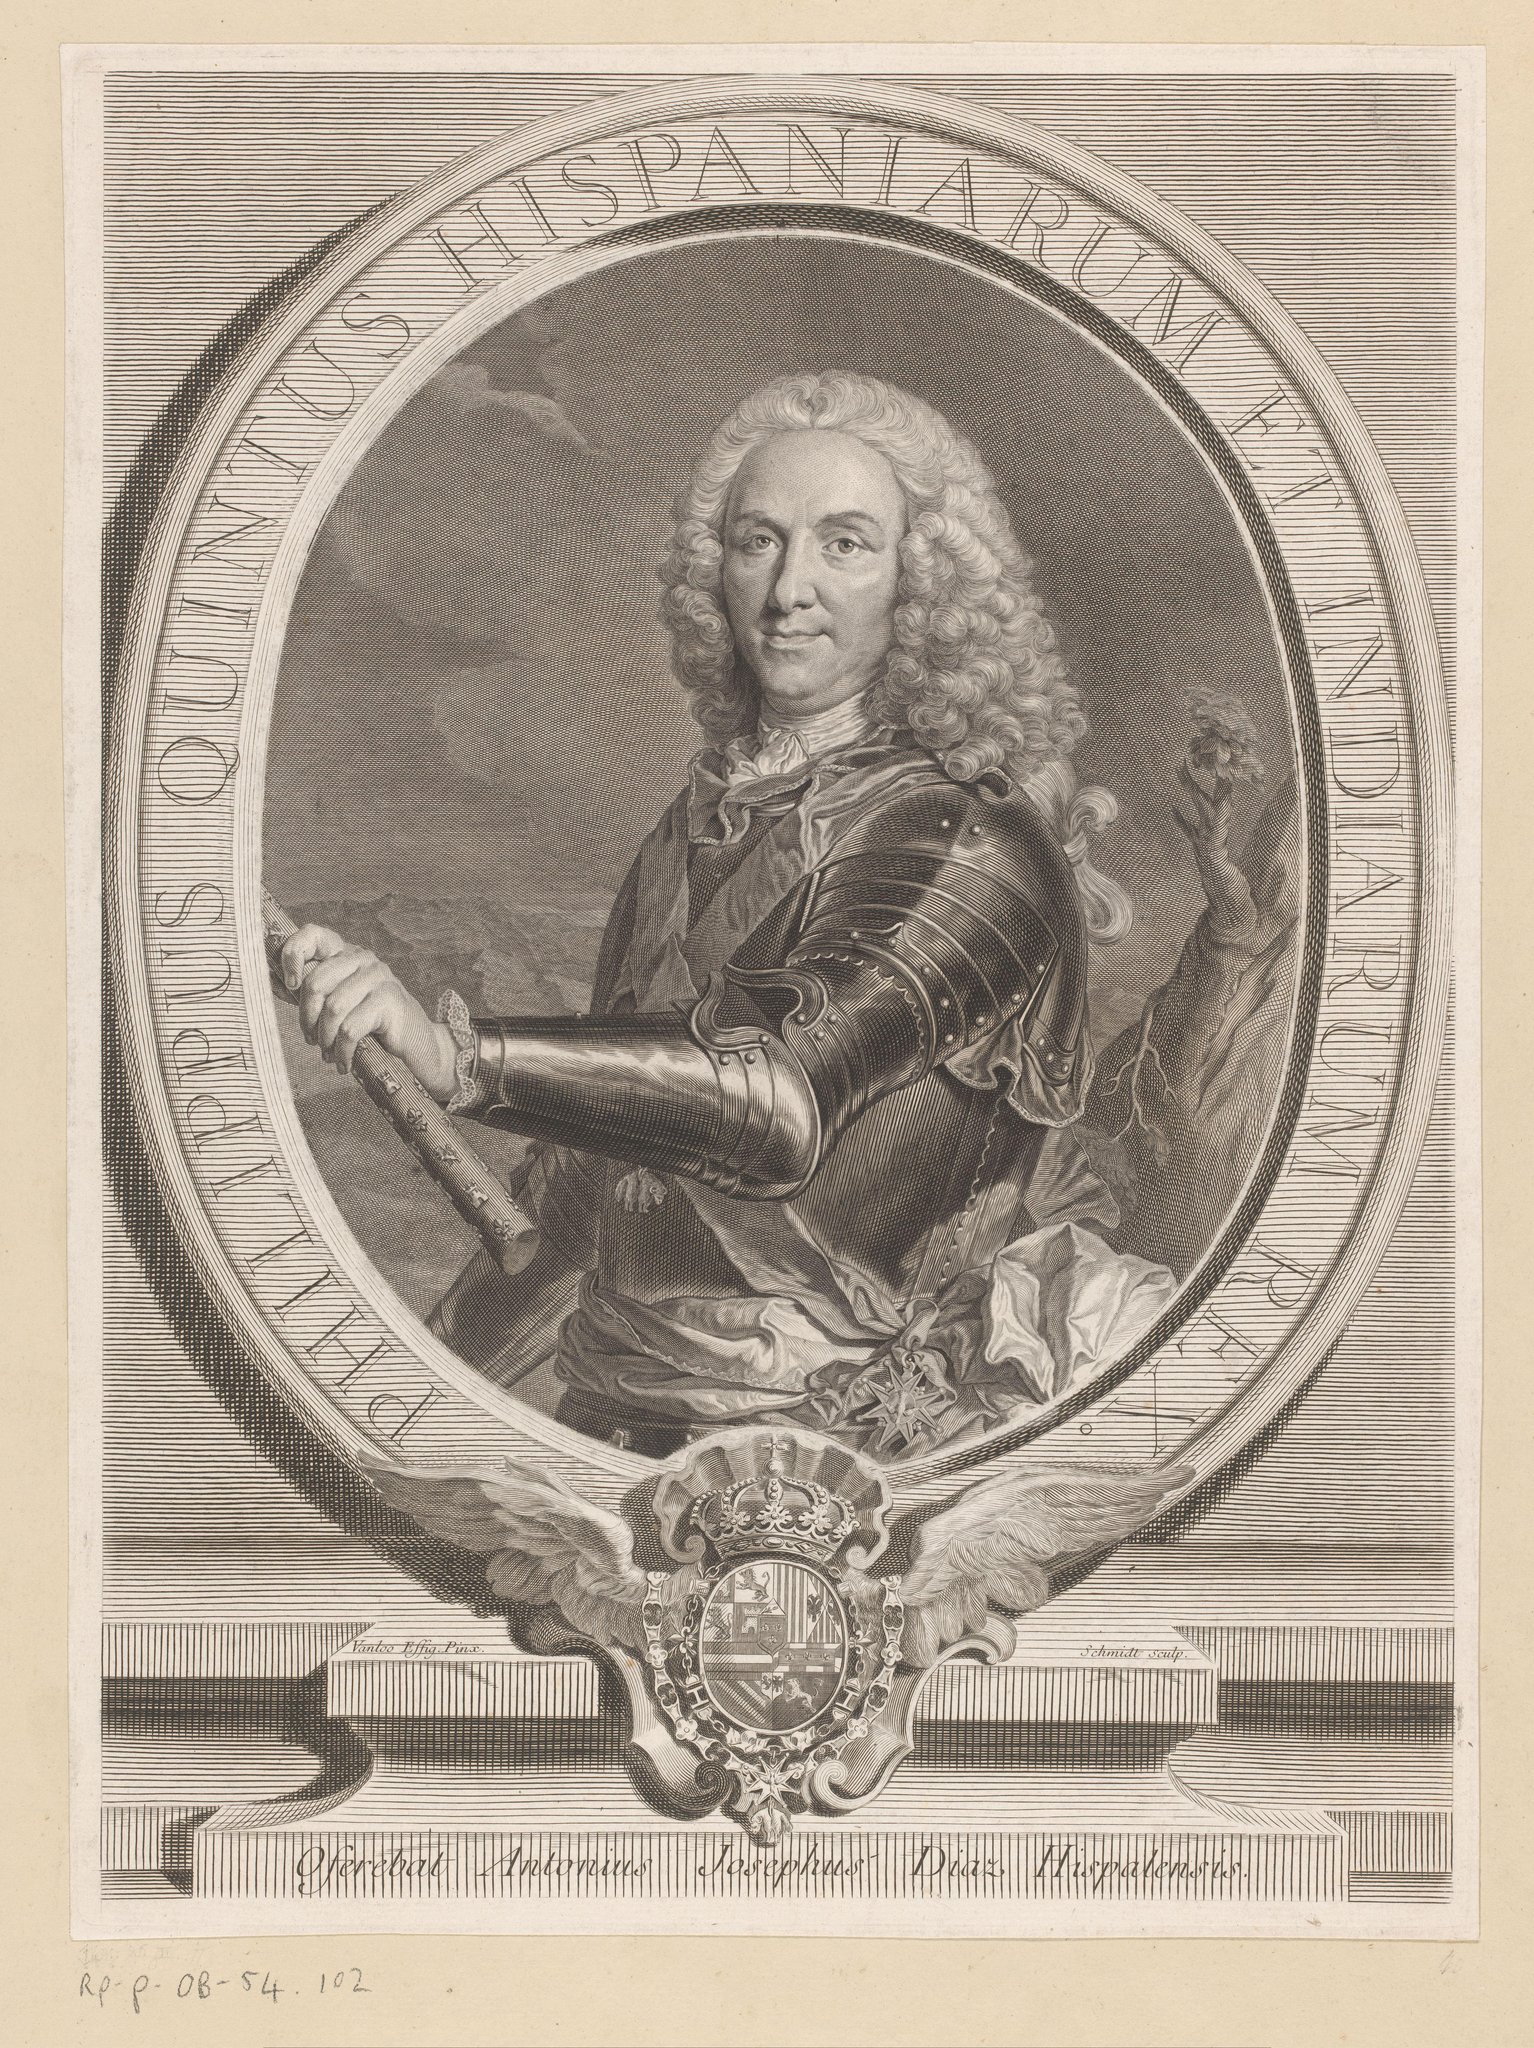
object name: print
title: Portret van Filips V, koning van Spanje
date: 1722-1775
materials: paper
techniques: engraving, etching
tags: filips v (koning van spanje), historical persons, armorial bearing, heraldry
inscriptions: collector's mark: Lugt 240